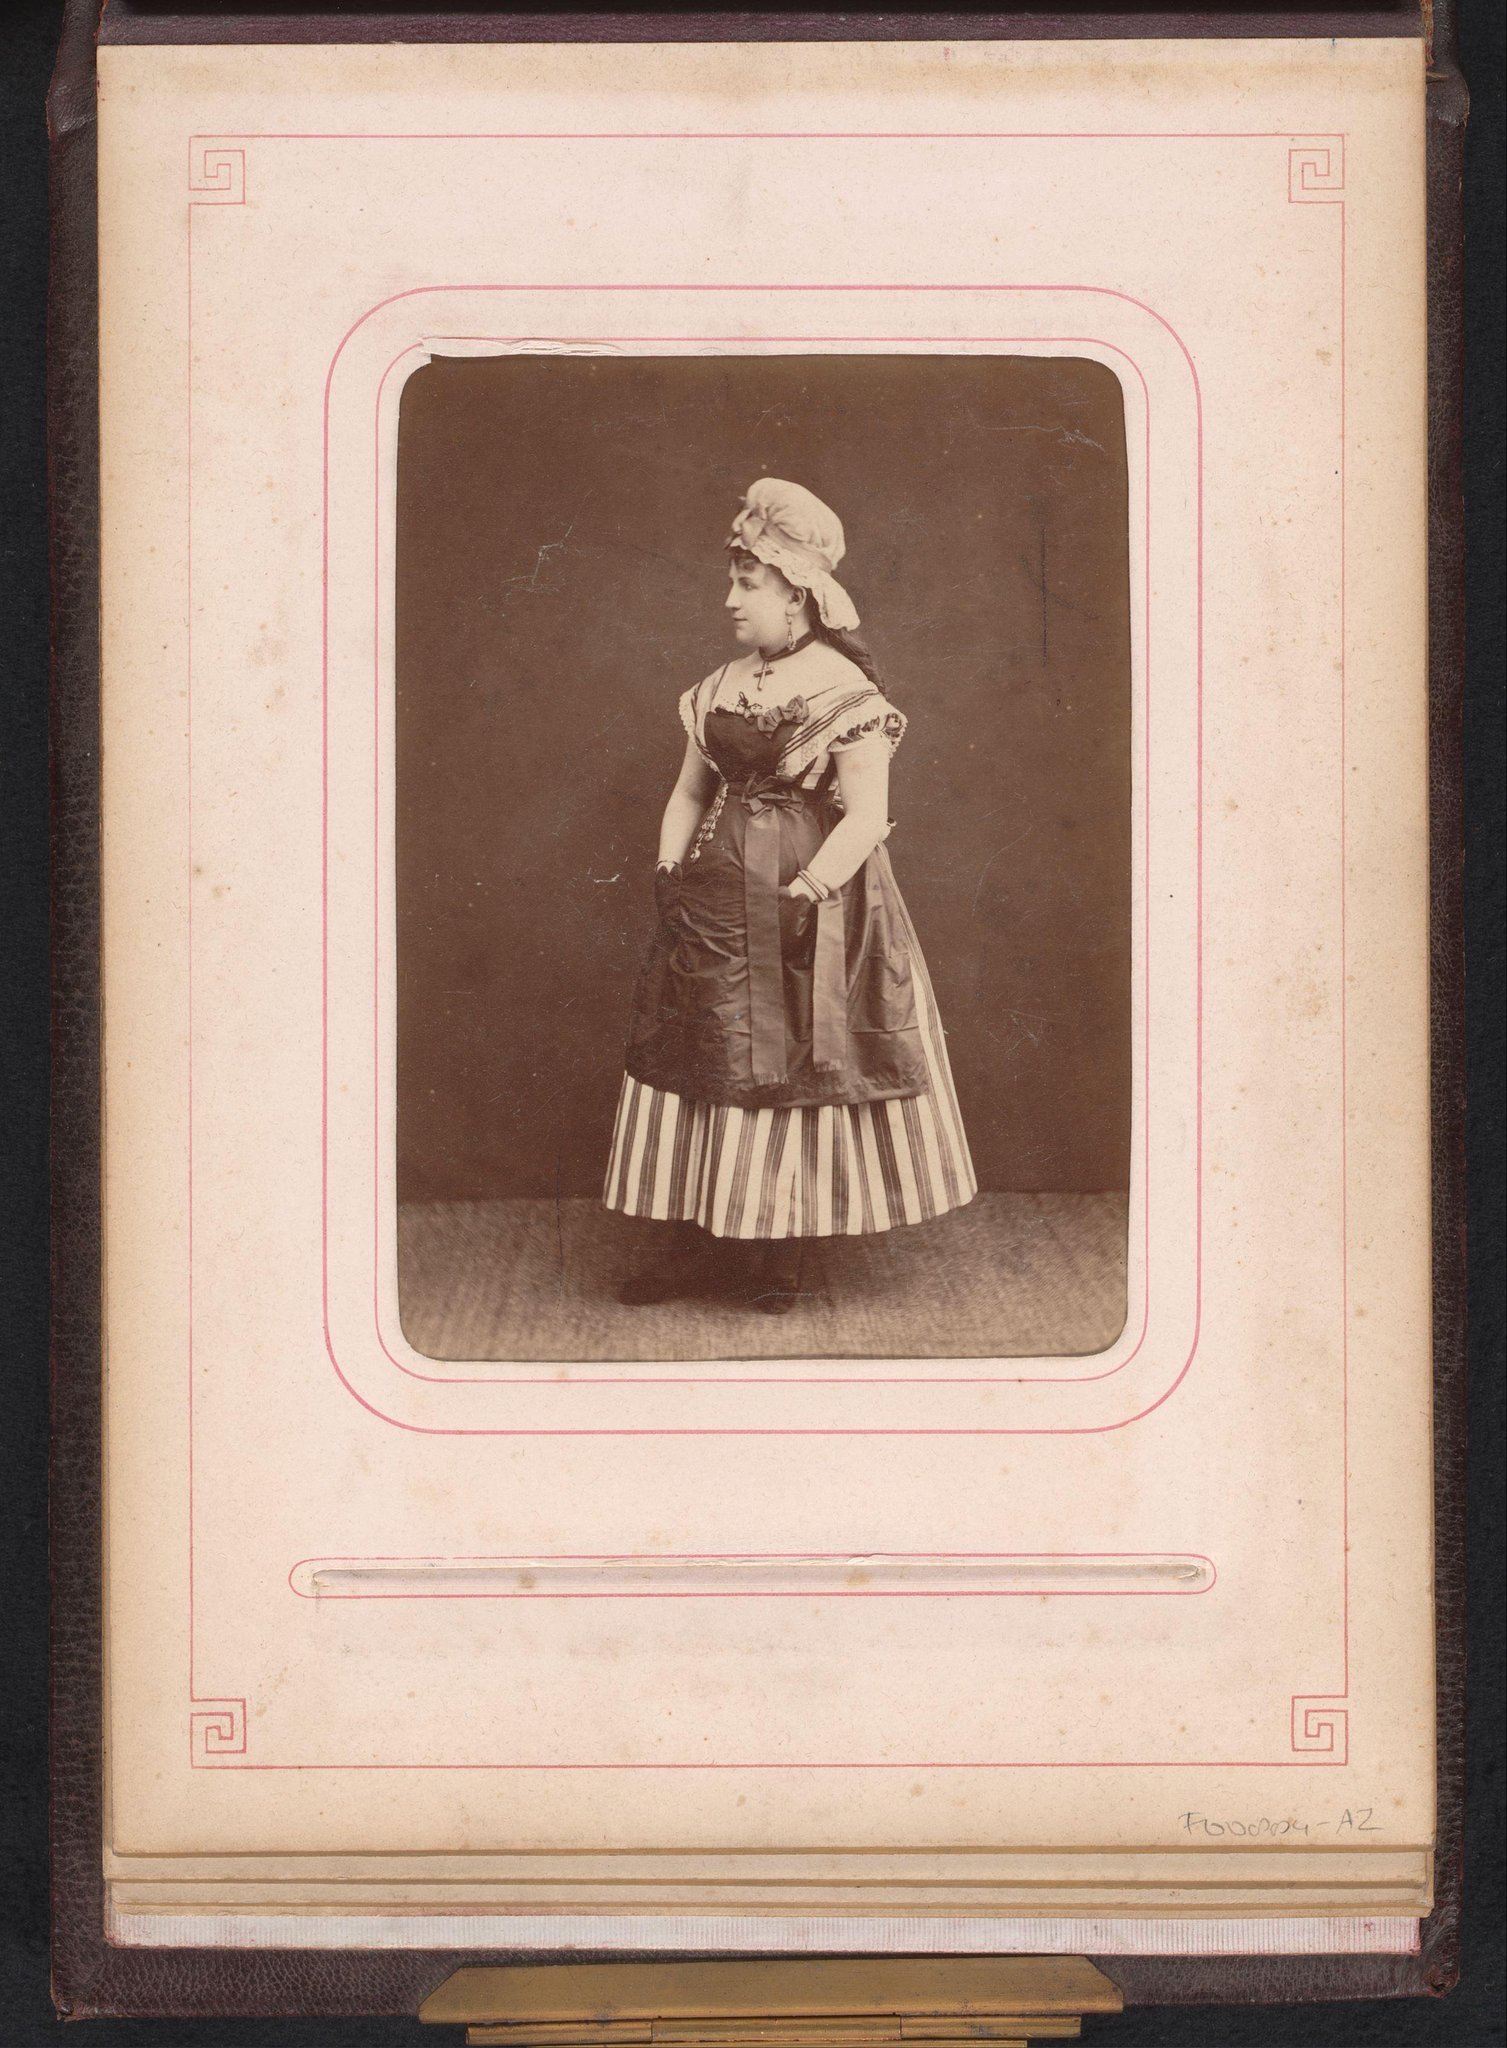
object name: cabinet photograph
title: Portret van een staande vrouw in een gestreepte jurk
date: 1868-1917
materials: cardboard, paper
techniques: albumen print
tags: adult woman, historical persons, dress, gown, the hague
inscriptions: inscription: ‘M.M. Couvée/ Lange Pooten 41/ La Haye/ Specialité/ de/ Photographies/ en tous genres/ Vues de la Hollande/ Types de Costumes/ Portraits’, inscription: ‘Cabinet-Portrait./ Photographie/ De Lavieter & Cie./ Willemstraat No 2./ La Haye.’